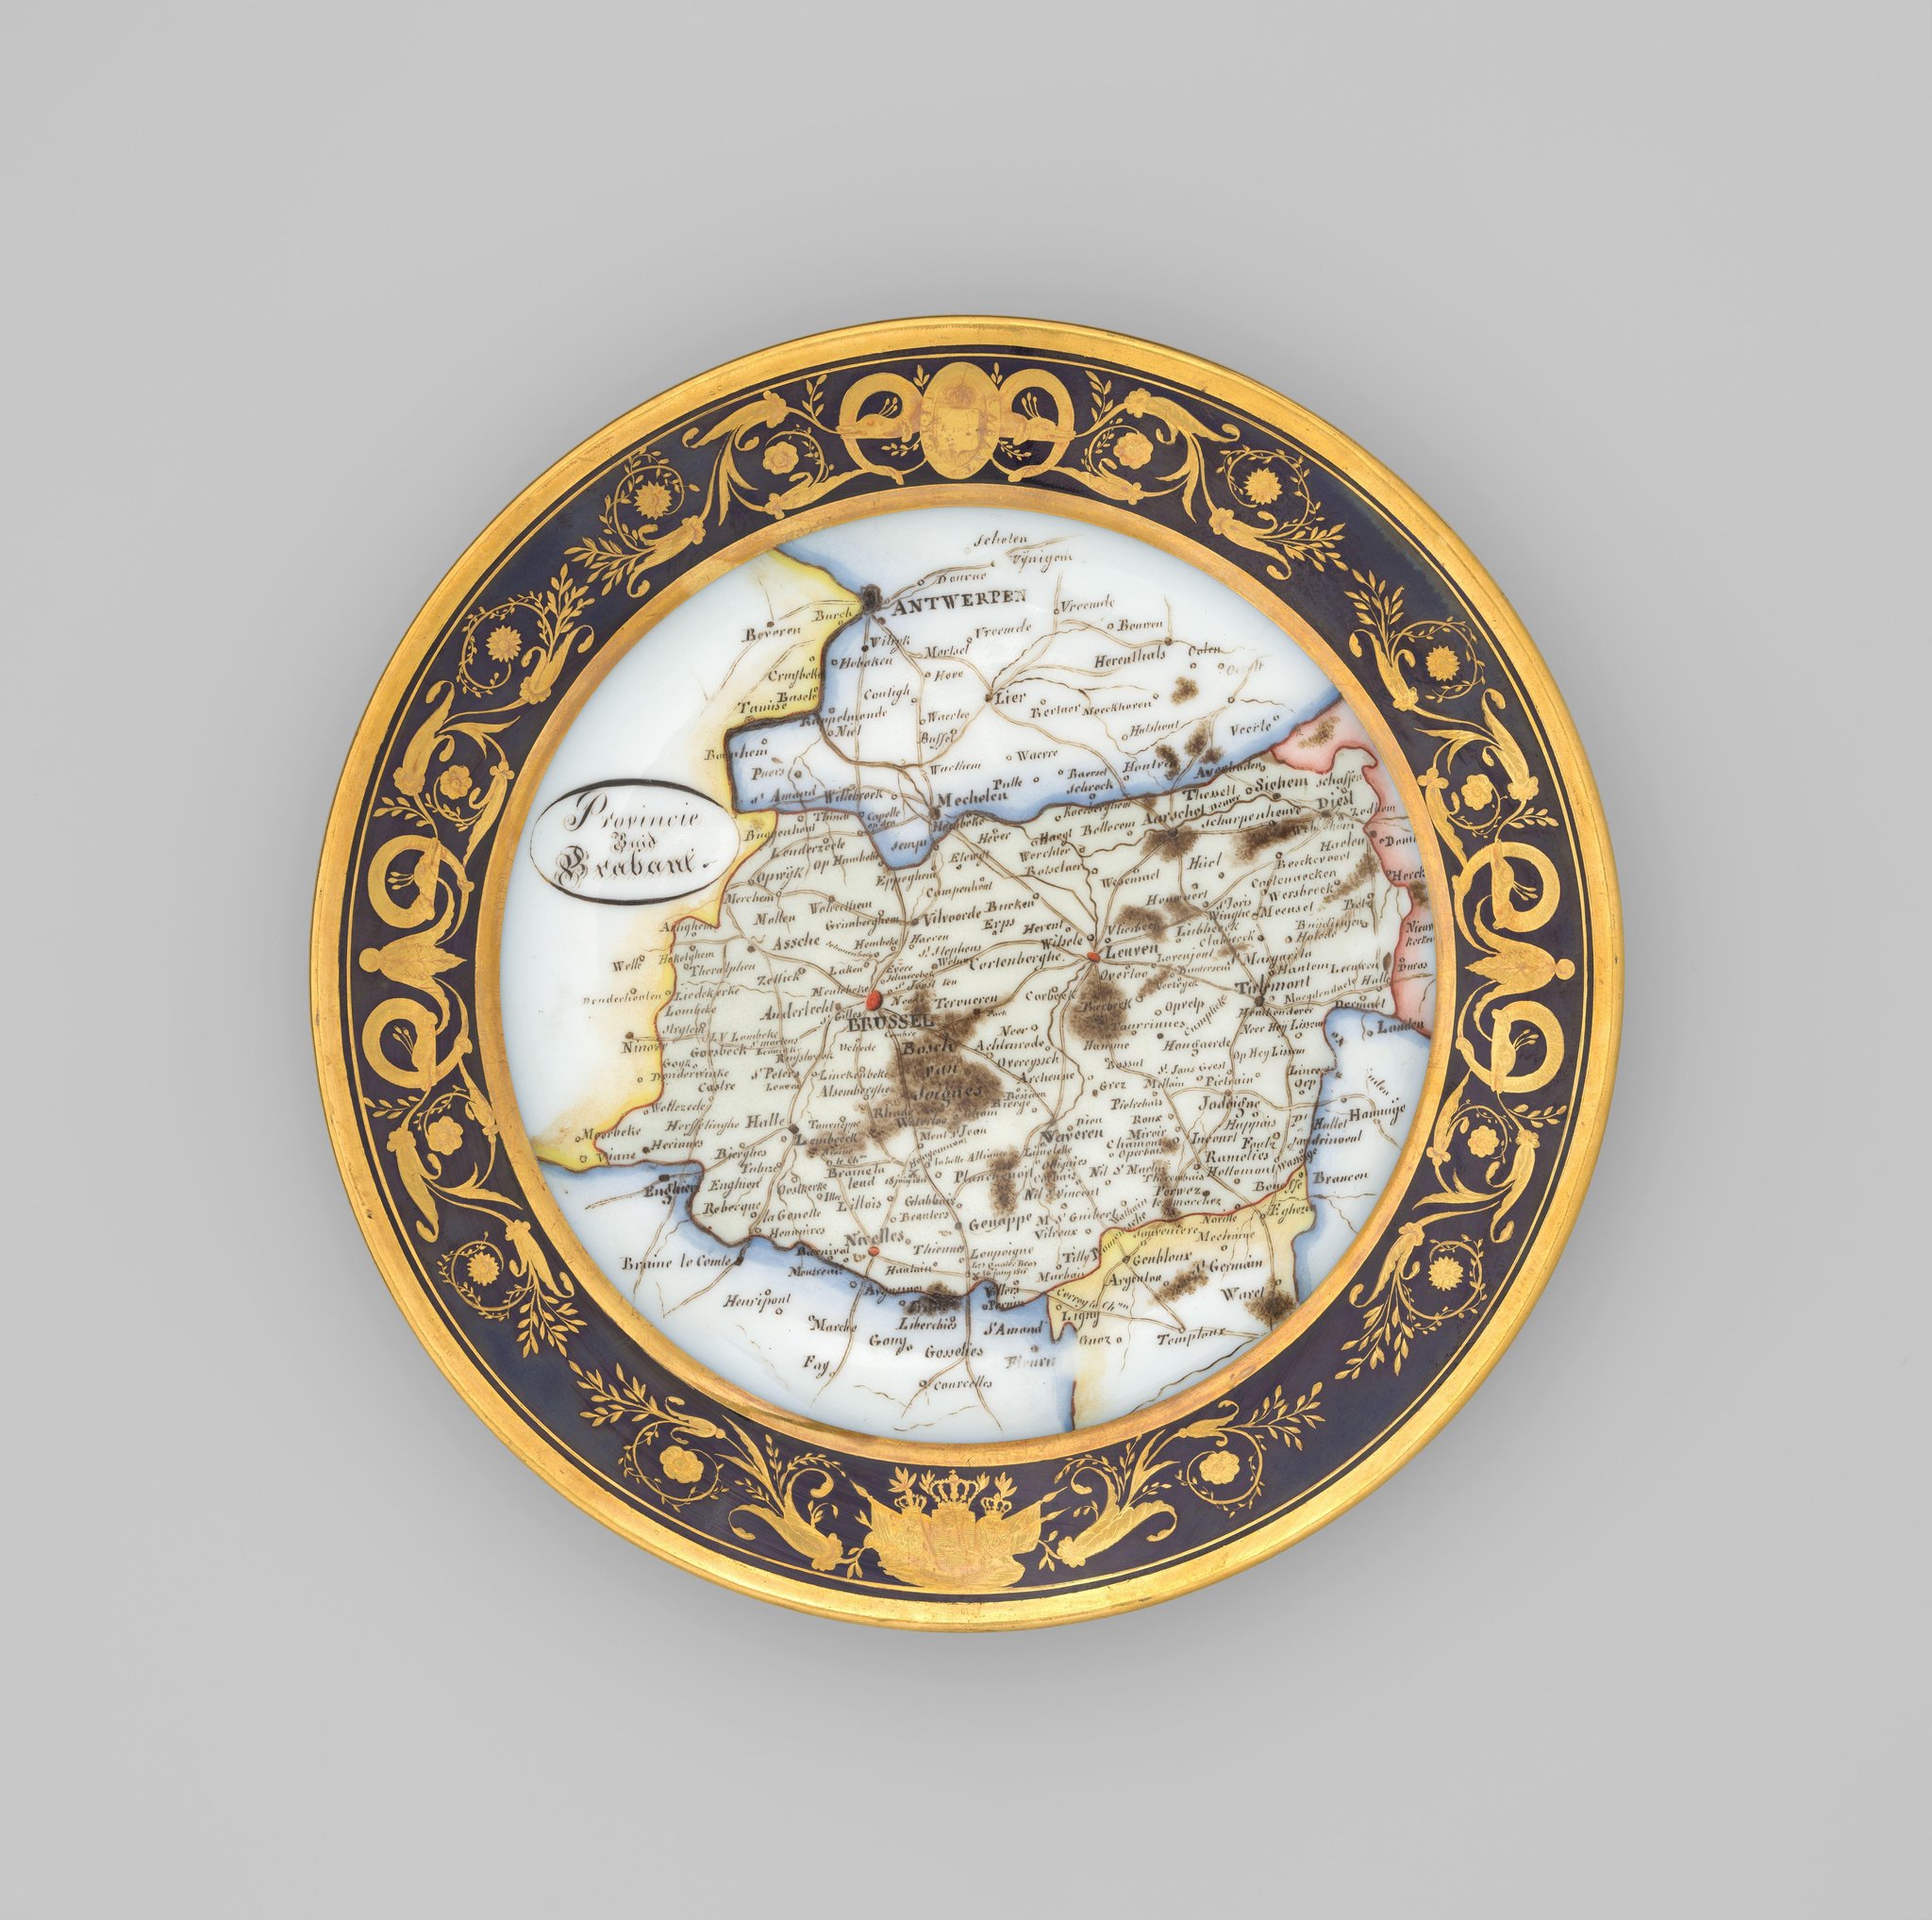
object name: plate dish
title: 18 plates, each decorated with a Netherlandish province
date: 1822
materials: glaze, gold, paint, porcelain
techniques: firing, gilding, turning, vitrification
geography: paris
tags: brabant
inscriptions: monogram and date: ‘R. D. 1822’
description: These plates reflect the period when the Netherlands and Belgium together formed the United Kingdom of the Netherlands (1815-1830). The kingdom consisted of 17 provinces plus the grand duchy of Luxembourg. The gold decoration is in the Neoclassical style. On the upper edge are the arms of the kingdom, on the lower border those of each province. Today the Netherlands consists of 12 provinces.